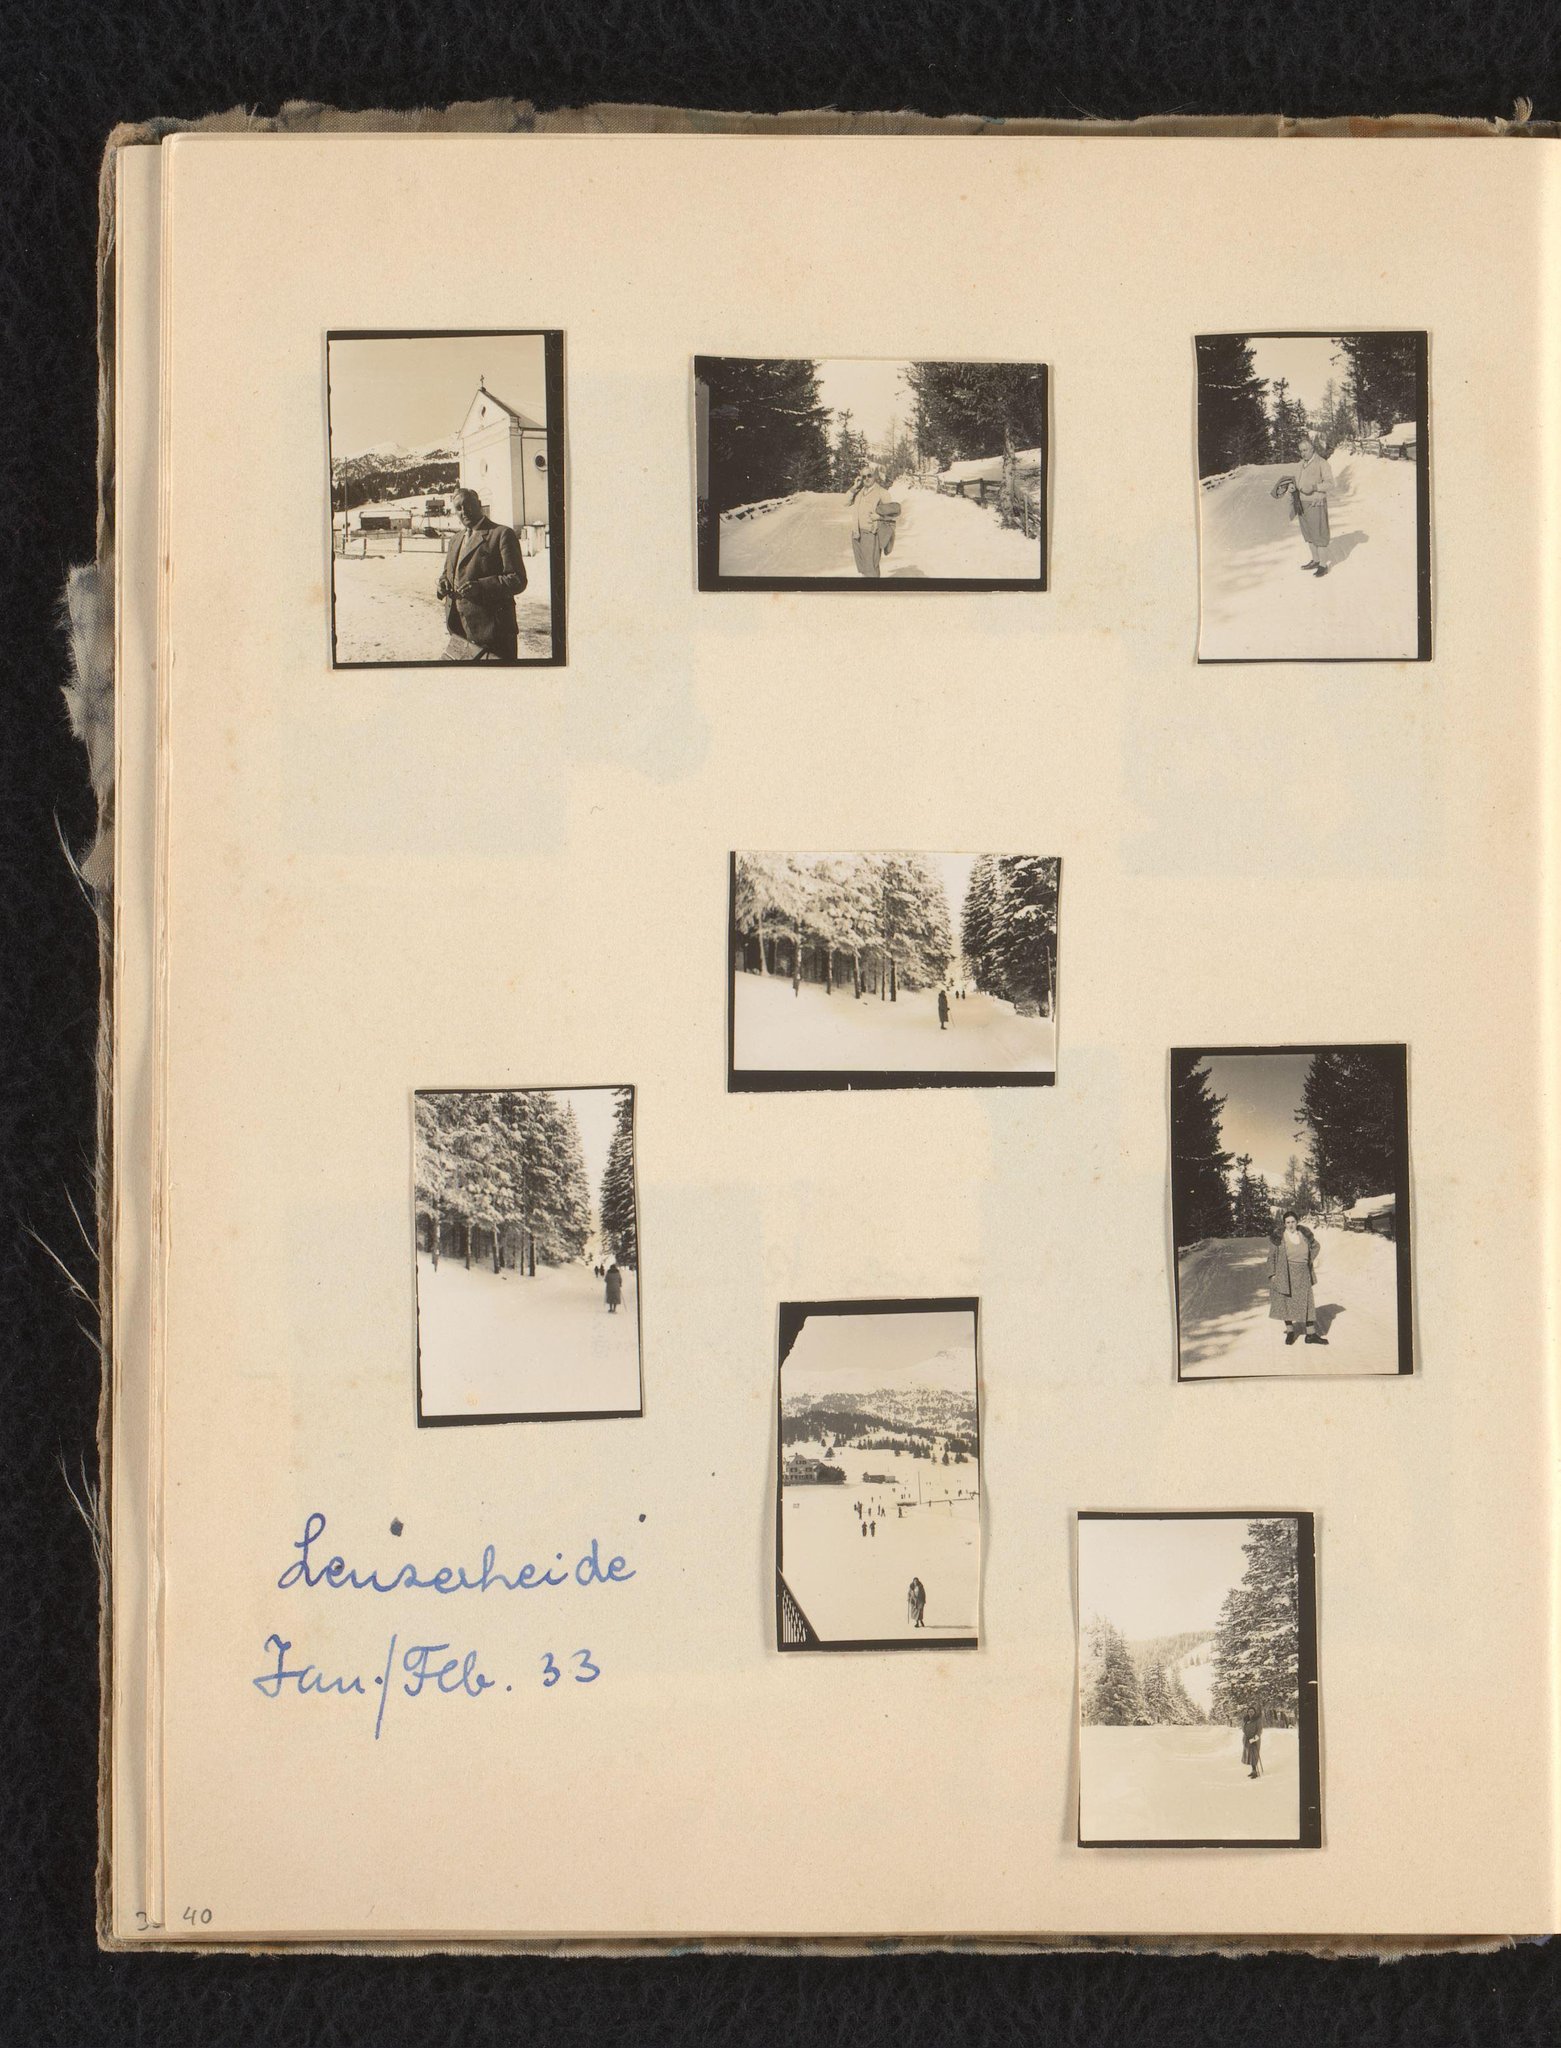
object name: photograph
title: Eugen Wachenheimer en zijn echtgenote Else Wachenheimer-Moos op skivakantie in winterlandschap, januari - februari 1933, Lenzerheide (Zwitserland)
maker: else wachenheimer-moos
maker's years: 1895-1944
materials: paper, photographic support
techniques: gelatin silver print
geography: switzerland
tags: eugen wachenheimer, else wachenheimer-moos, the family travelling, on holiday, winter sports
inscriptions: inscription: ‘Lenzerheide Jan./Feb. 33’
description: Blad bevat acht foto's van Eugen Wachenheimer (in trui) en Else Wachenheimer-Moos (in lange jas). Onderdeel van het fotoalbum van de reizen die Eugen en Else Wachenheimer jaarlijks maakten rondom de viering van hun huwelijksdag en verloving.